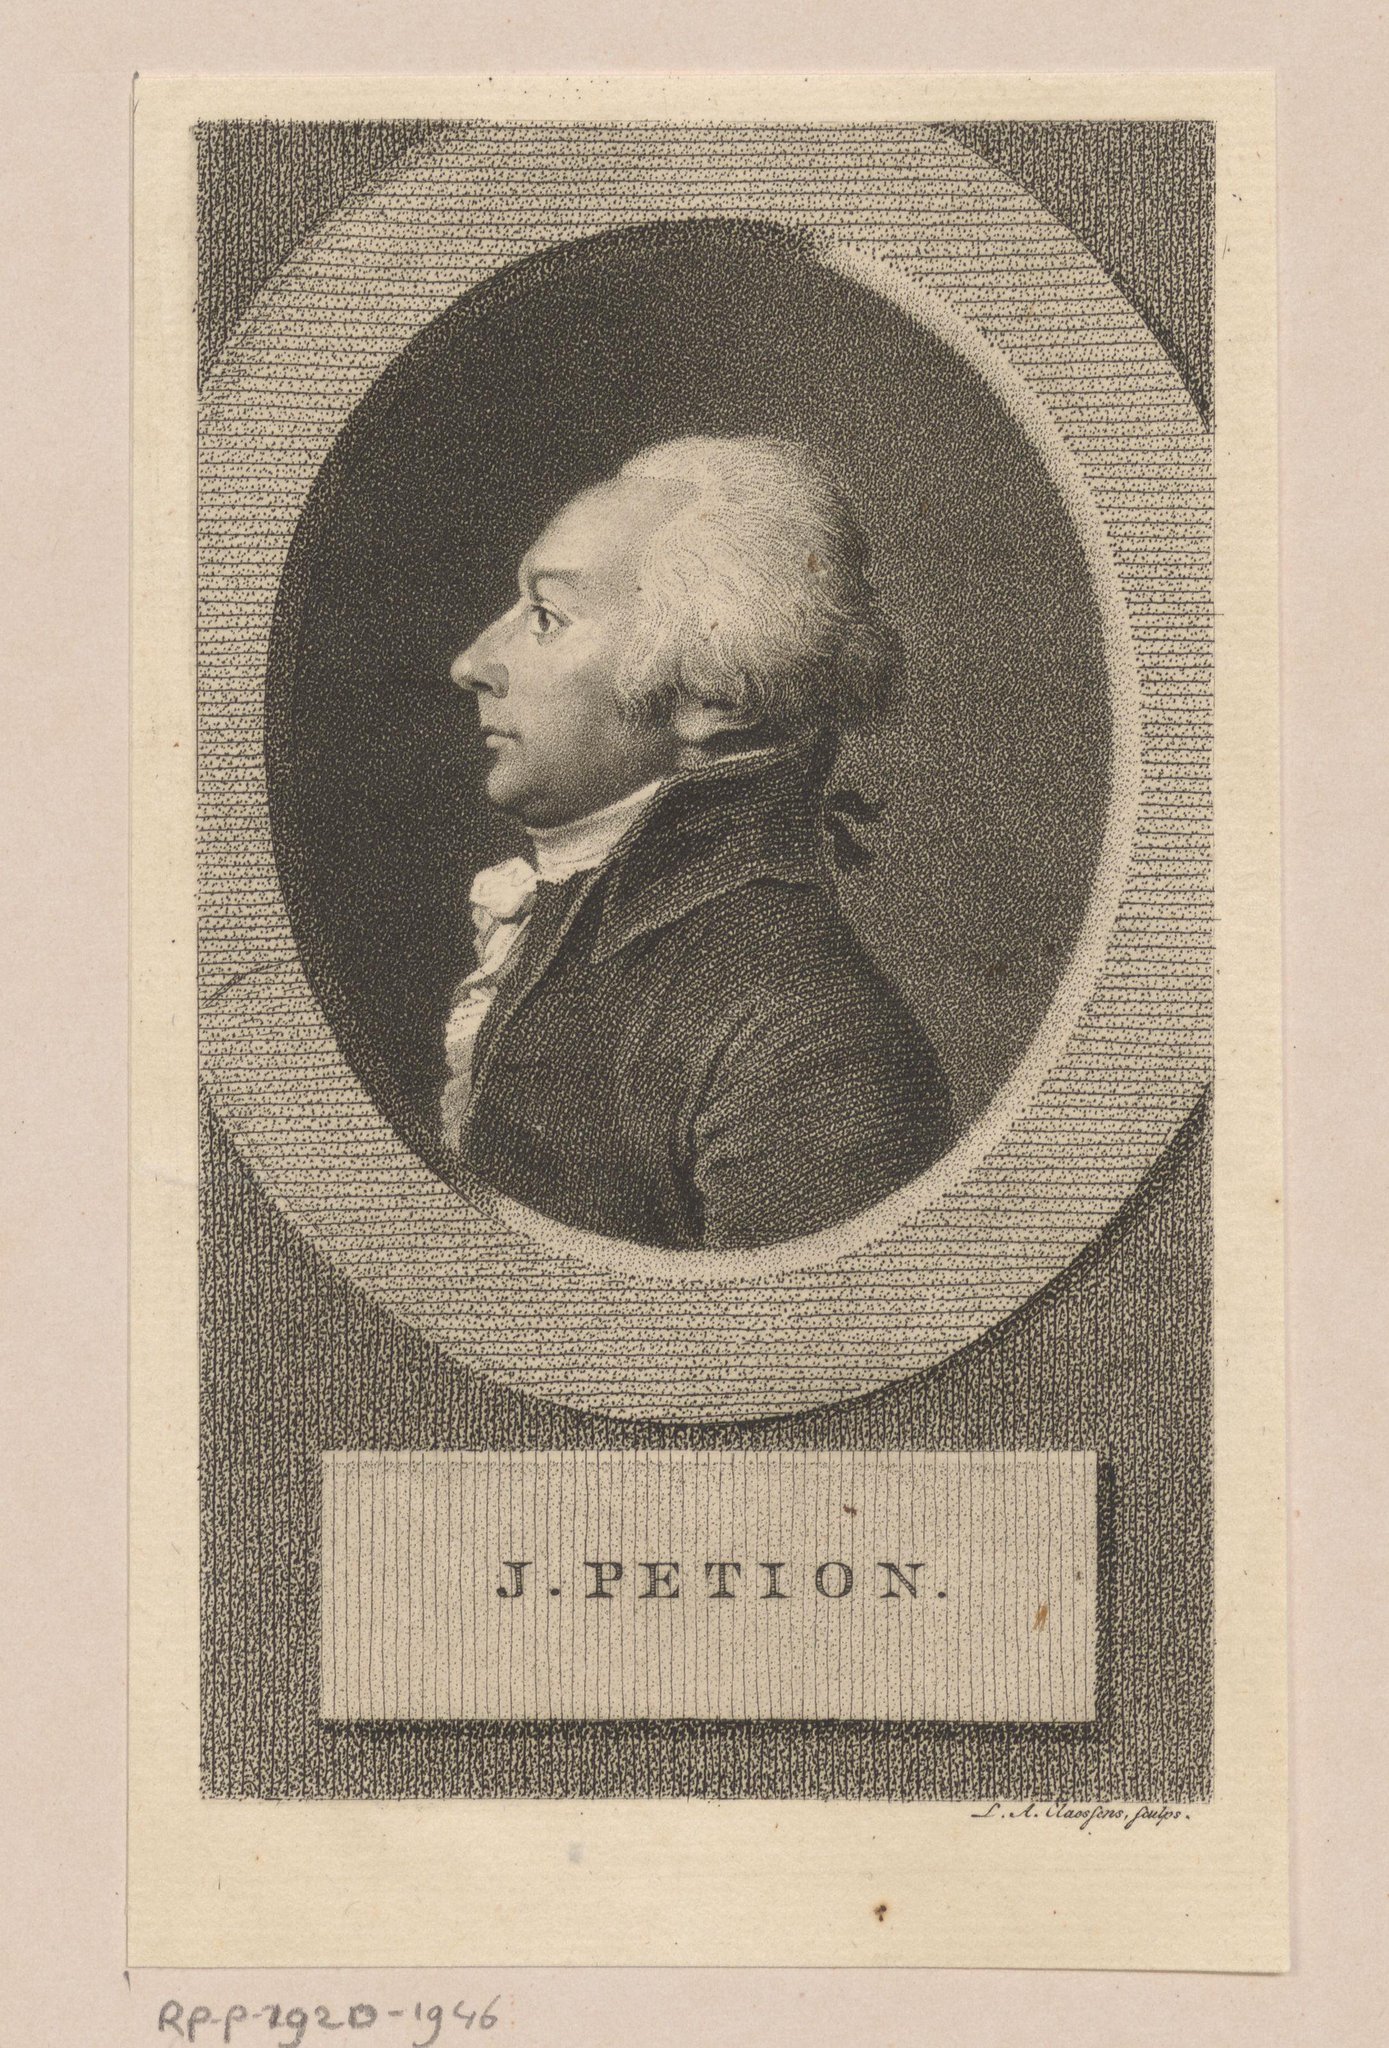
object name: print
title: Portret van Jérôme Pétion de Villeneuve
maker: lambertus antonius claessens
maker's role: draughtsman, print maker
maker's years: 1763-1834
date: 1773-1834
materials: paper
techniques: engraving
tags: politician, adult man, historical persons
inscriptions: collector's mark: Lugt 2228